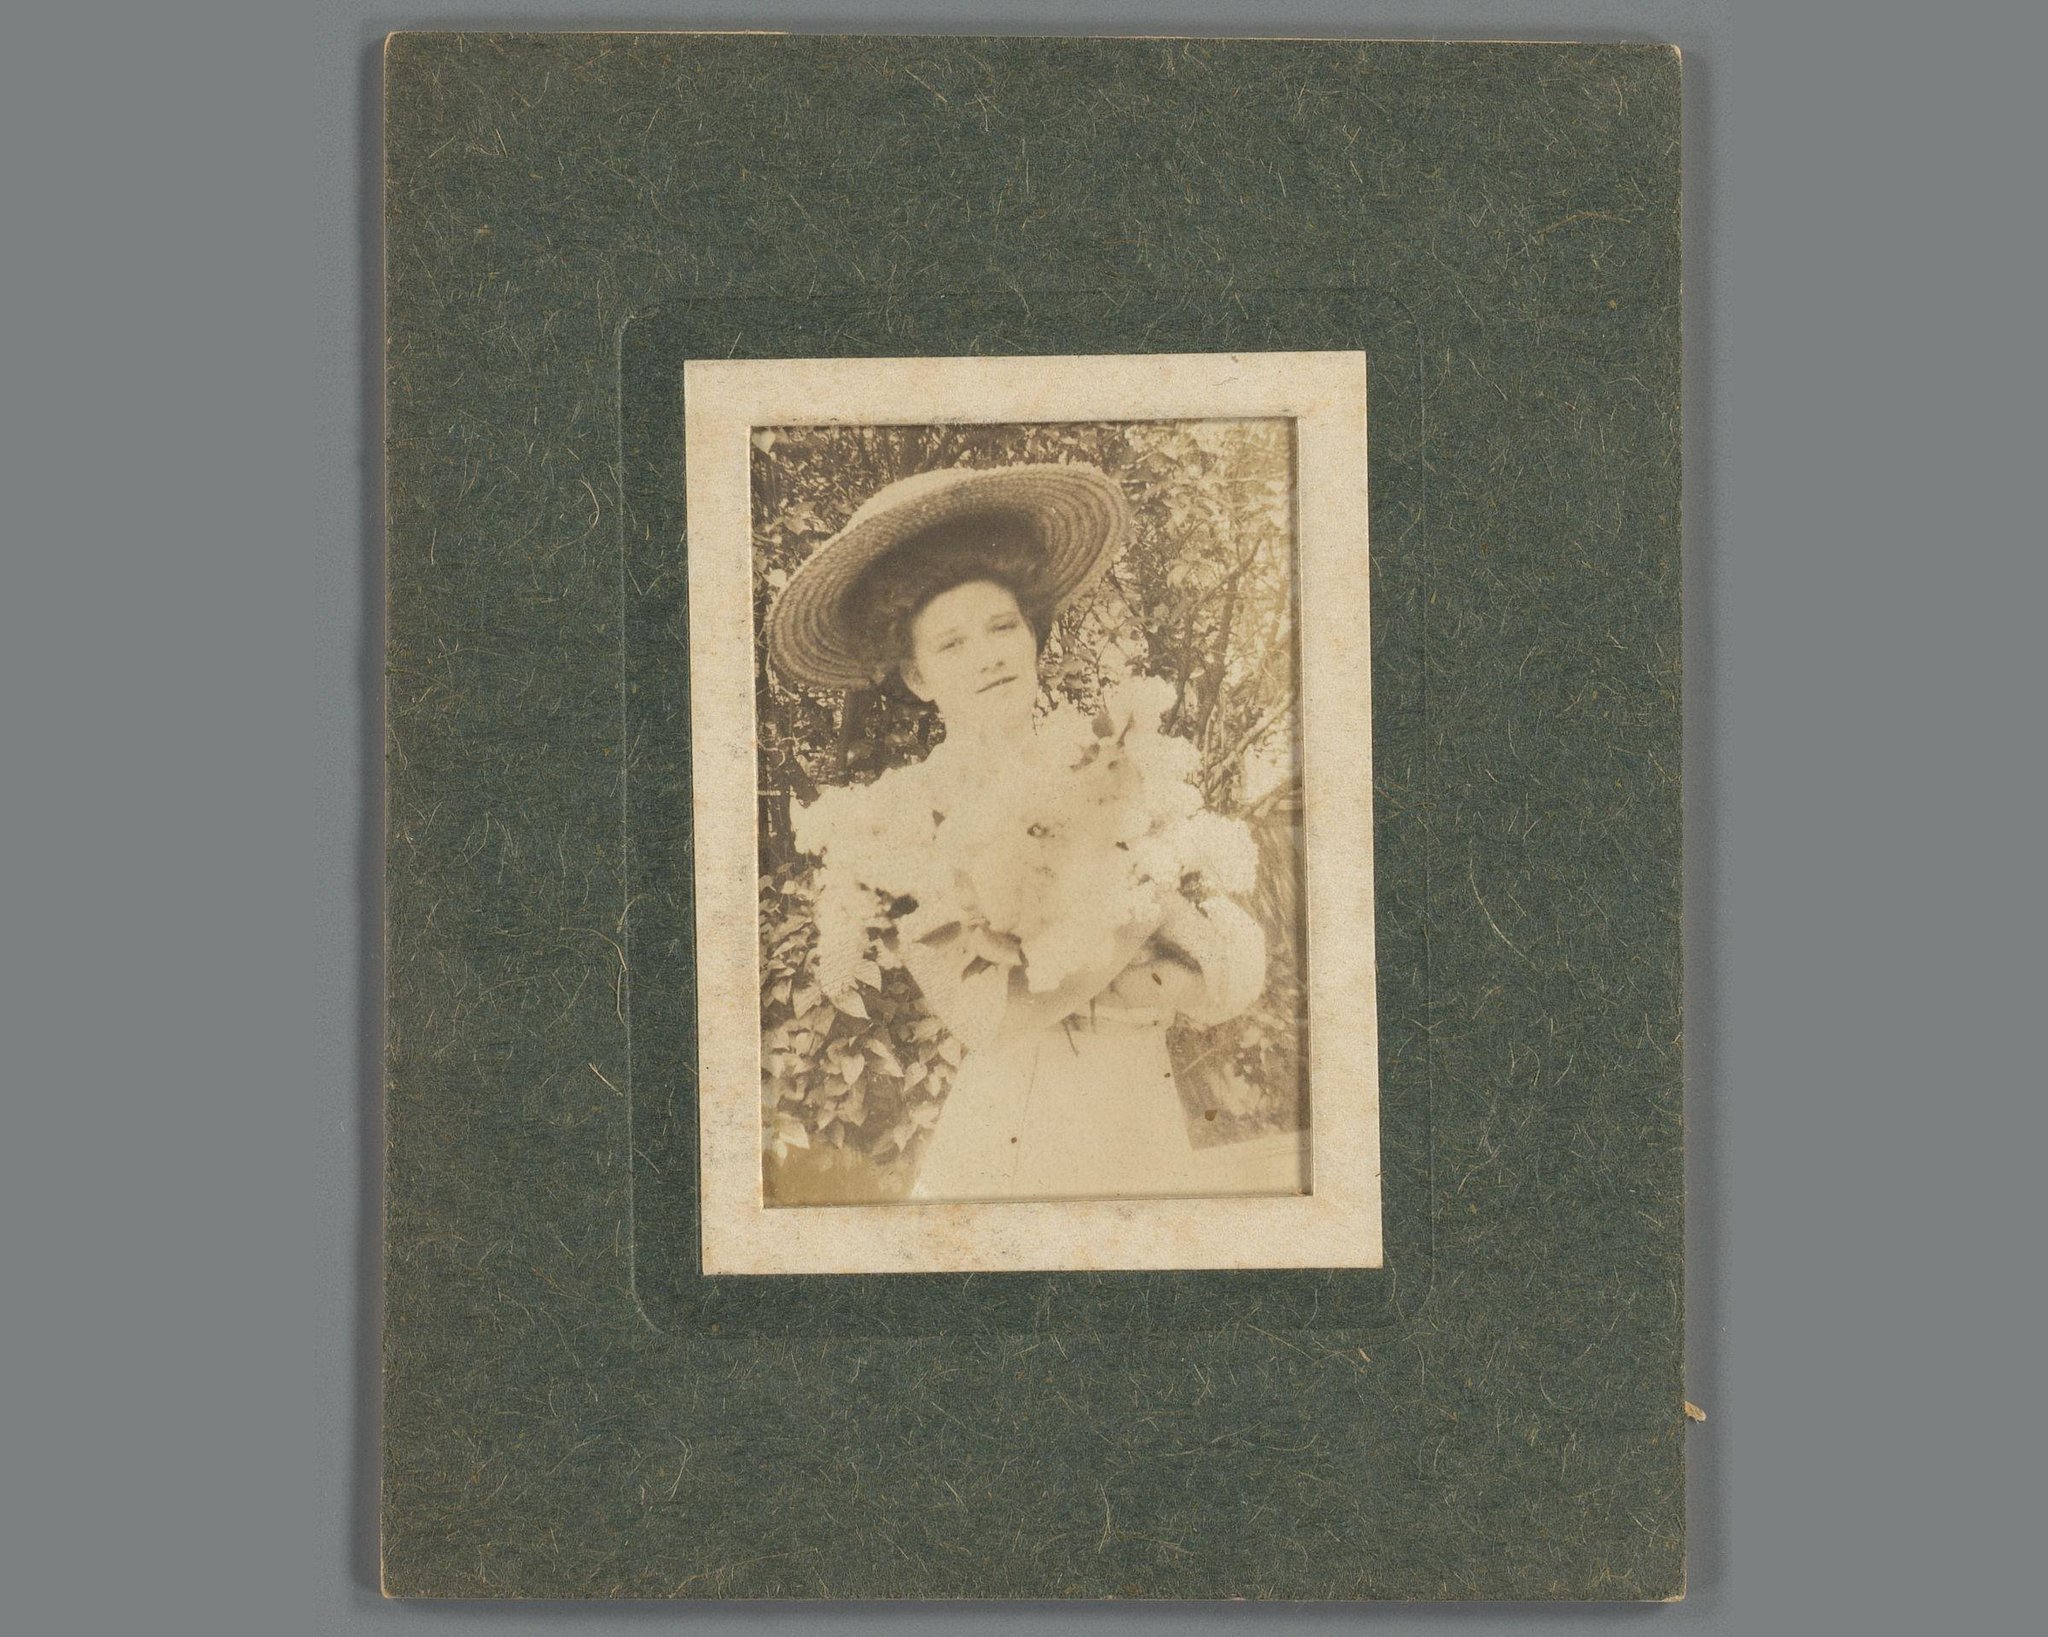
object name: photograph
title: Portret van een onbekende jonge vrouw met hoed in een tuin; gevat in lijst van karton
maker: Anonymous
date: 1890-1920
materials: paper, cardboard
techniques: gelatin silver print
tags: adolescent, young woman, maiden, garden, anonymous historical person portrayed